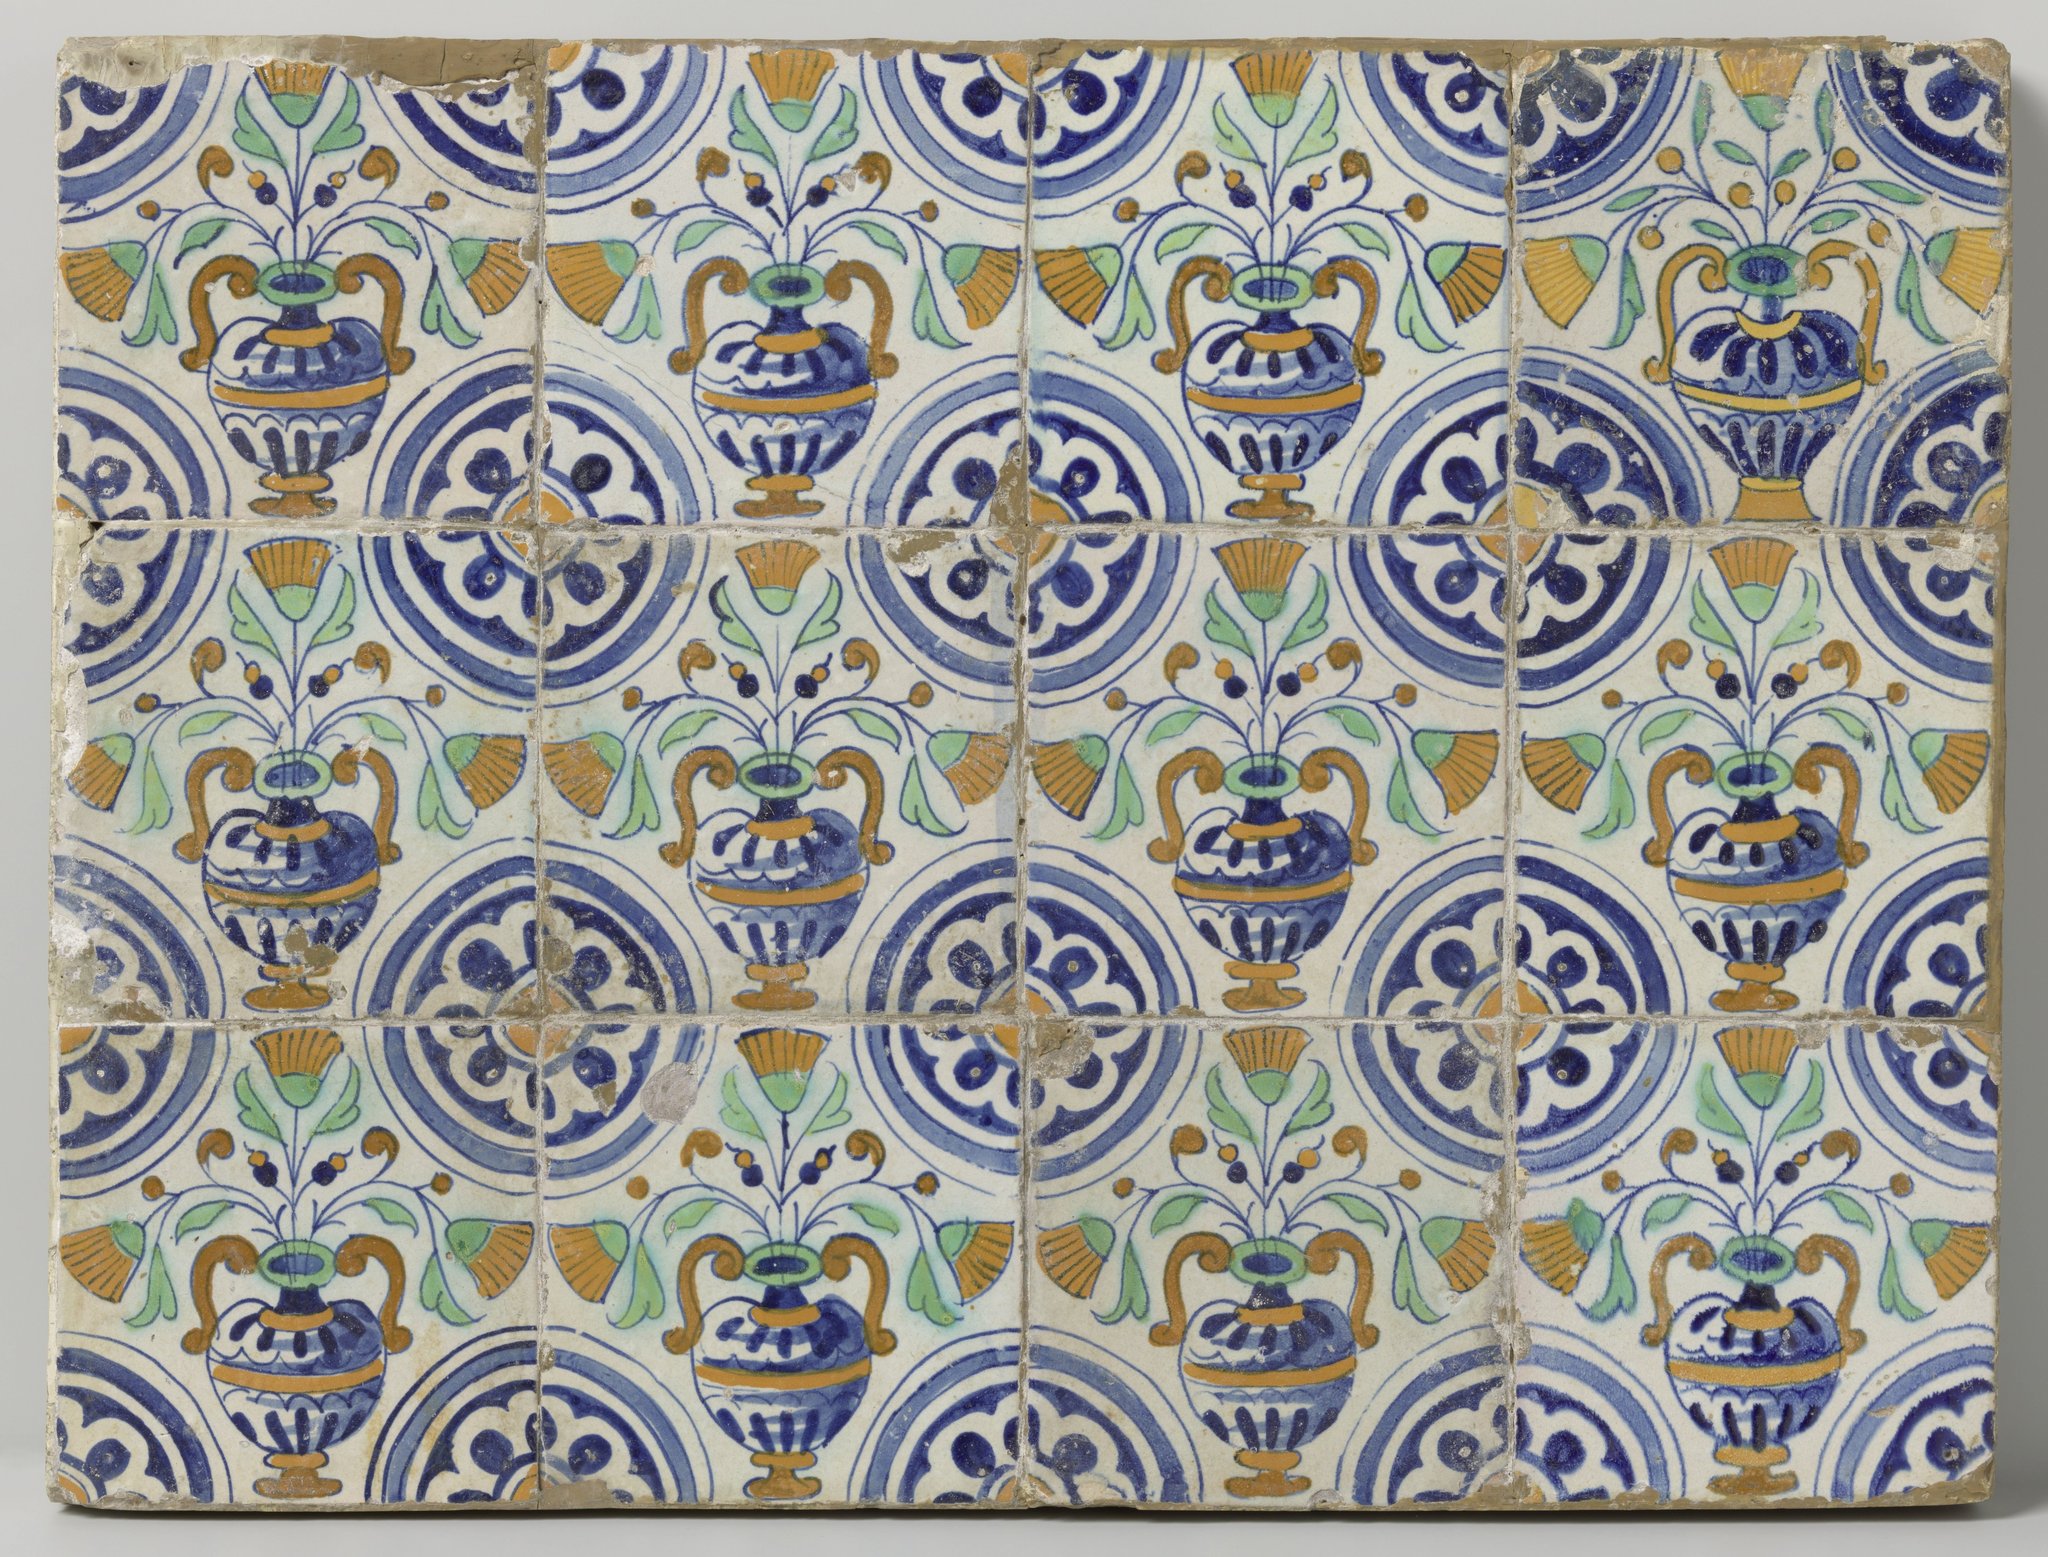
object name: tile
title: Veld van twaalf tegels met bloempotten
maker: Anonymous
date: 1610-1625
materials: earthenware, glaze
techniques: maiolica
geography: netherlands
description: Veld van twaalf tegels (3 x 4) elk met een veelkleurige (blauw, oranje, groen en geel) bloempot met goudsbloemen. In de hoeken, een kwart rozet.